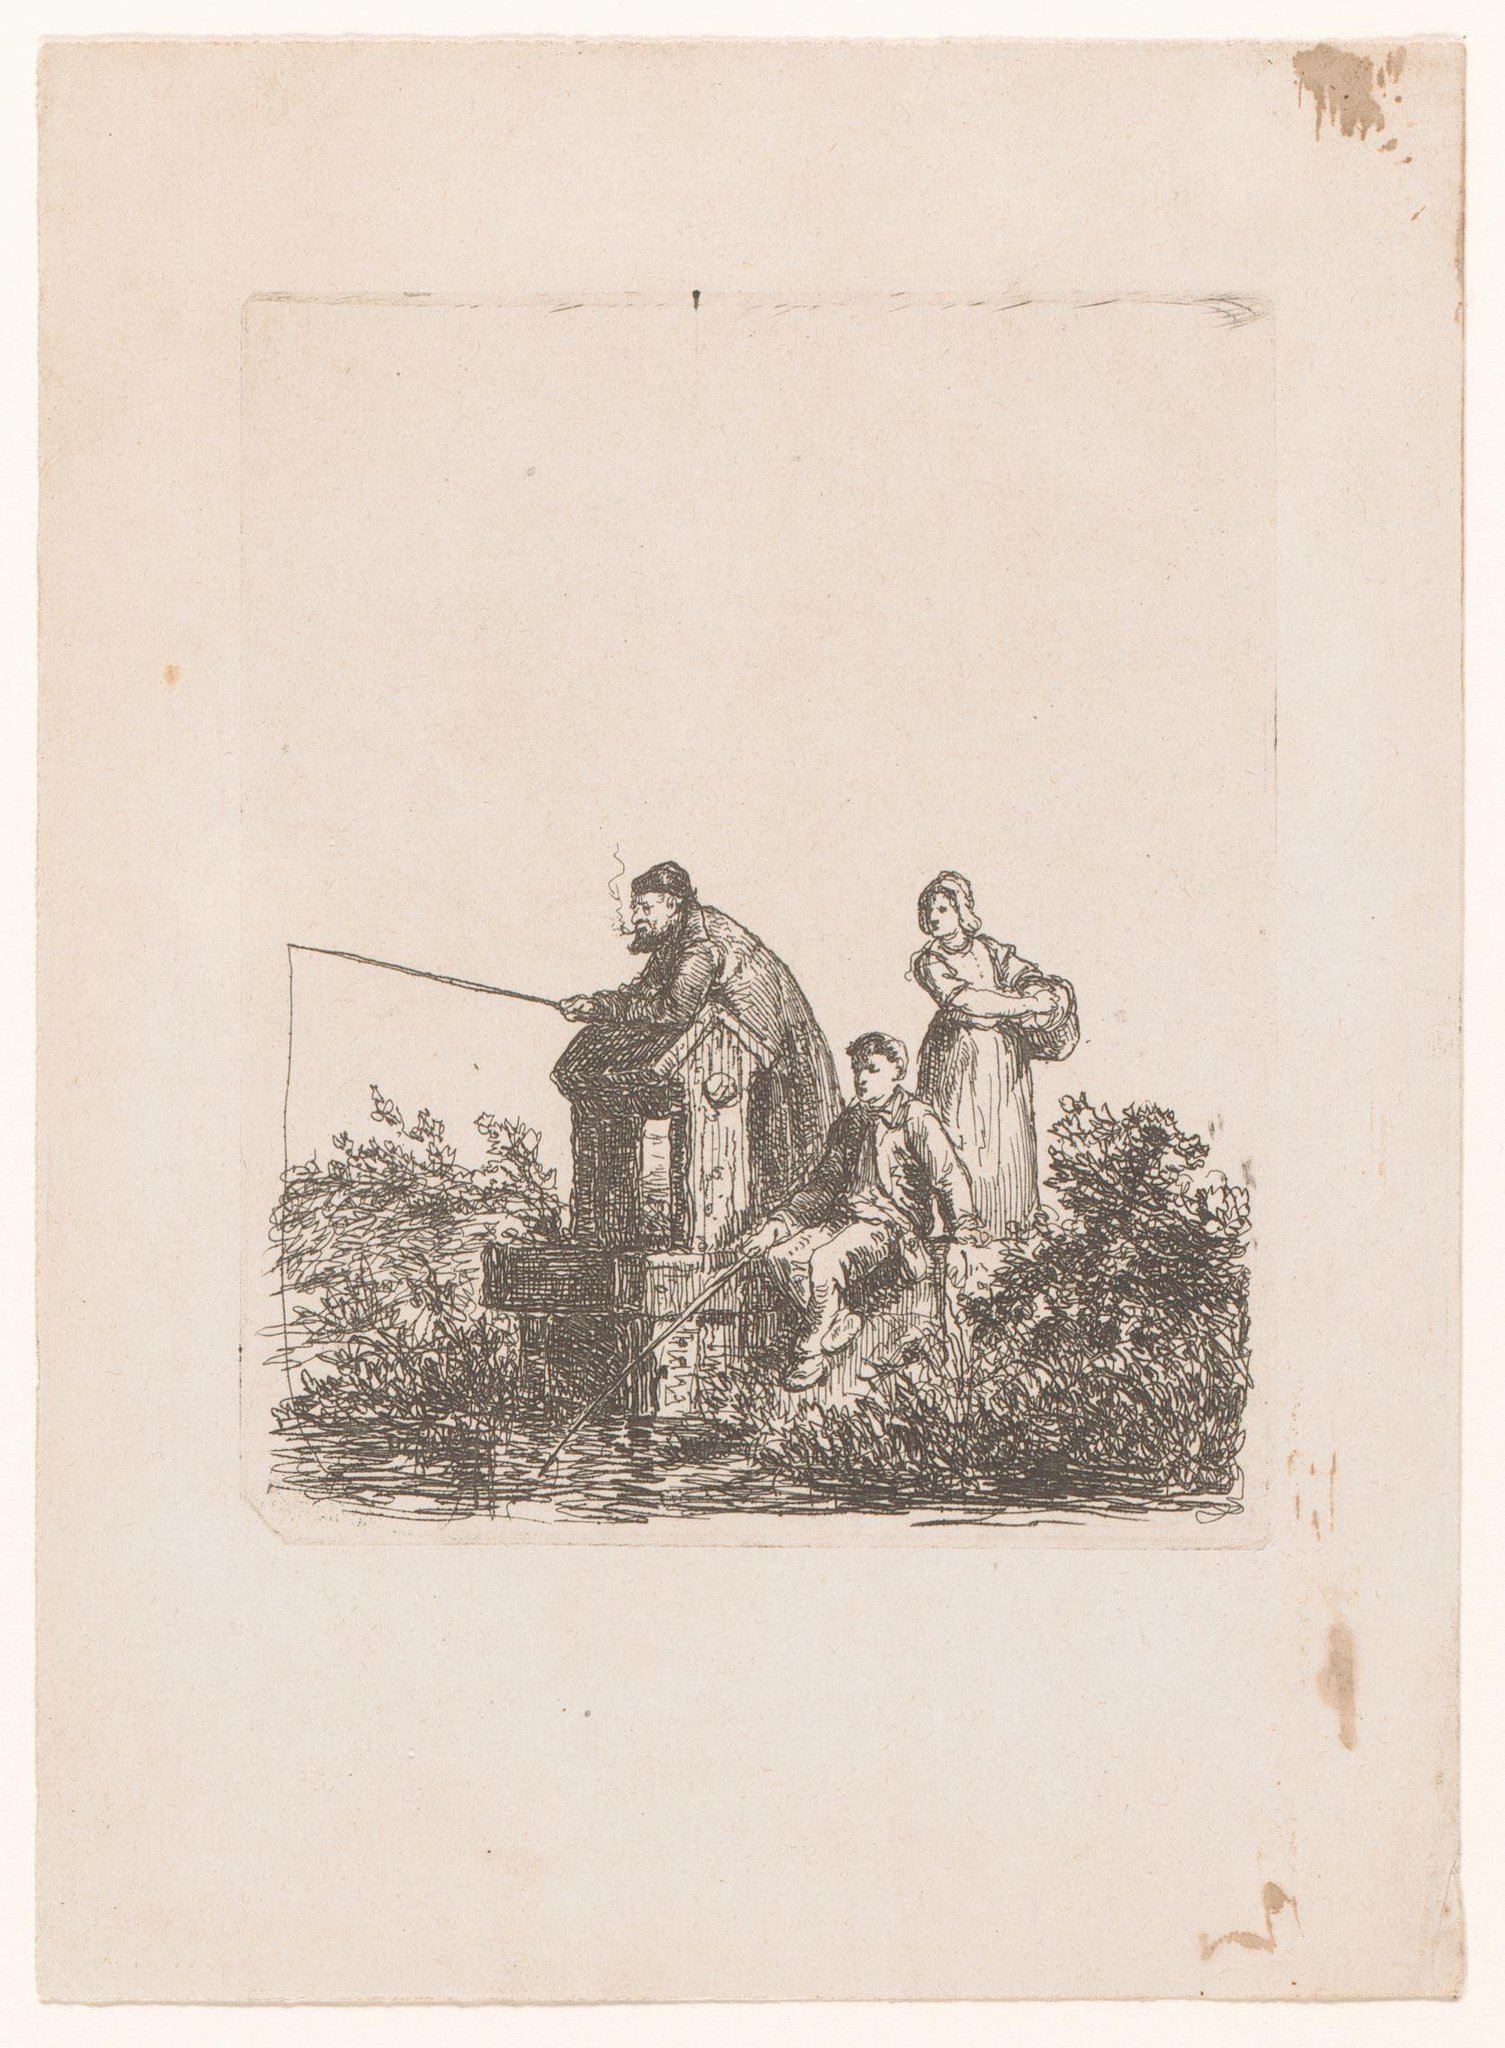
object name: print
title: Vissers met hengel aan het water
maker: henri françois schaefels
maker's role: print maker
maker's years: 1827-1904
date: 1862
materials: paper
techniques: etching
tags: angling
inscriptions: collector's mark: Lugt 2228